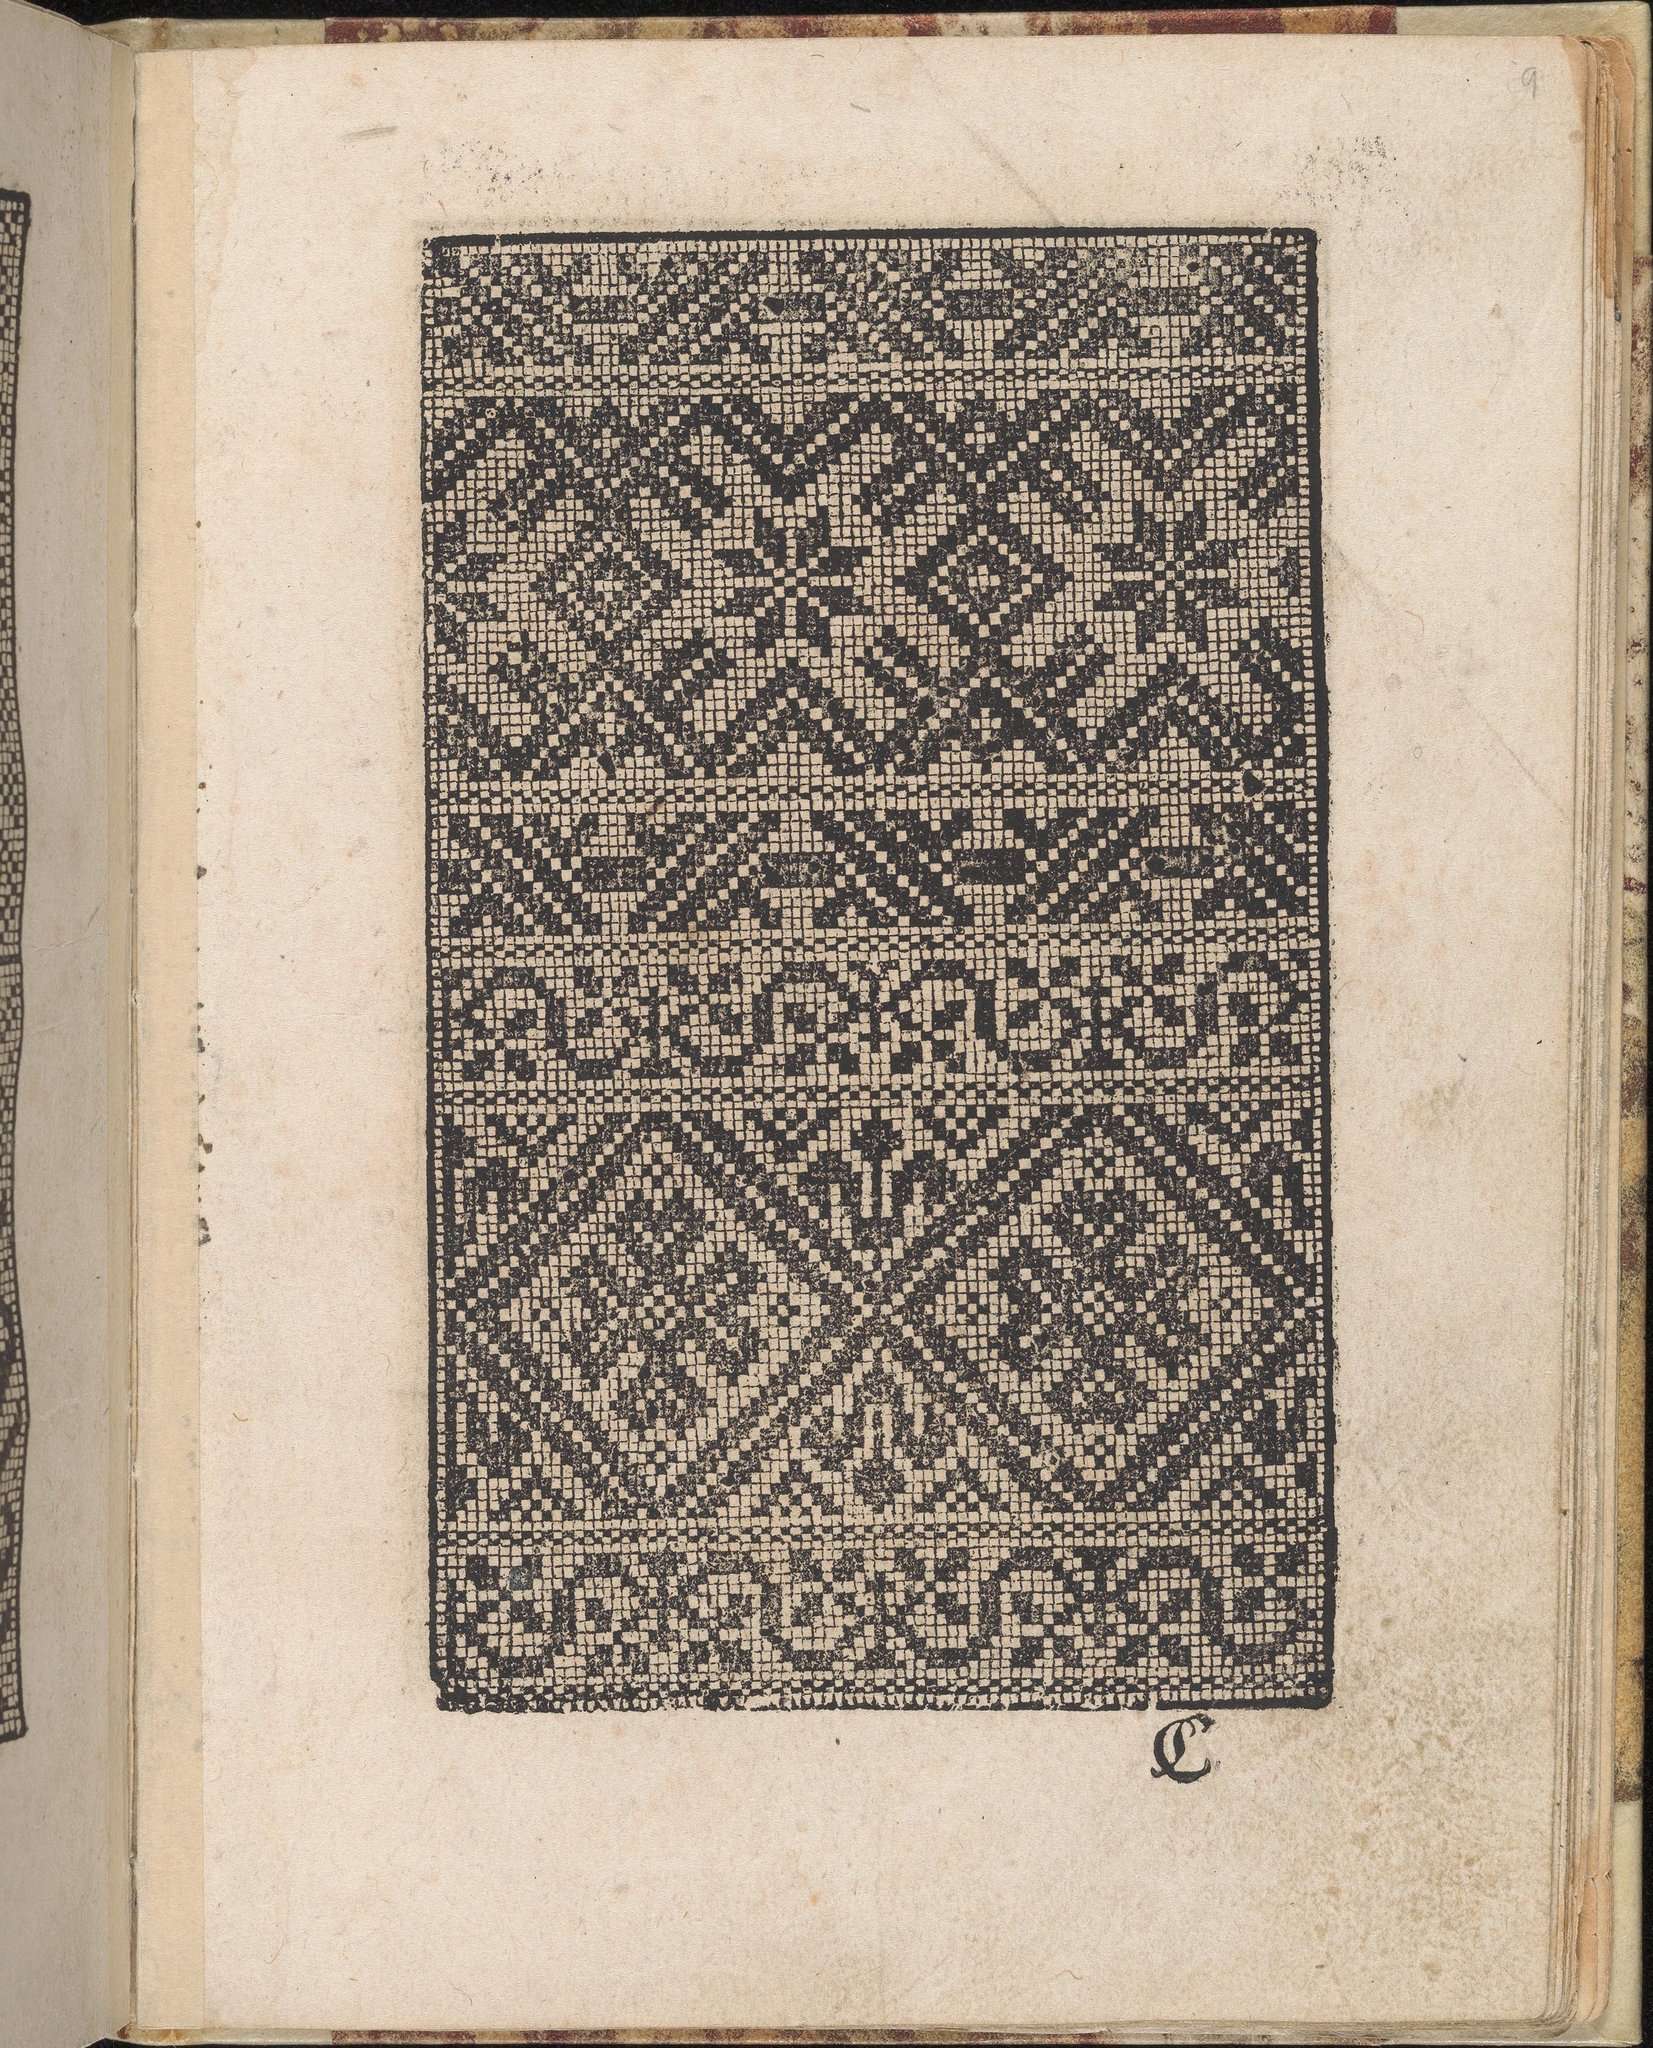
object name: book print ornament architecture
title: Ein new getruckt model Büchli...Page 9, recto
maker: johann schönsperger the younger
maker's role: publisher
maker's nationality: german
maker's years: 1490-1550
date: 1529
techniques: woodcut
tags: ornament